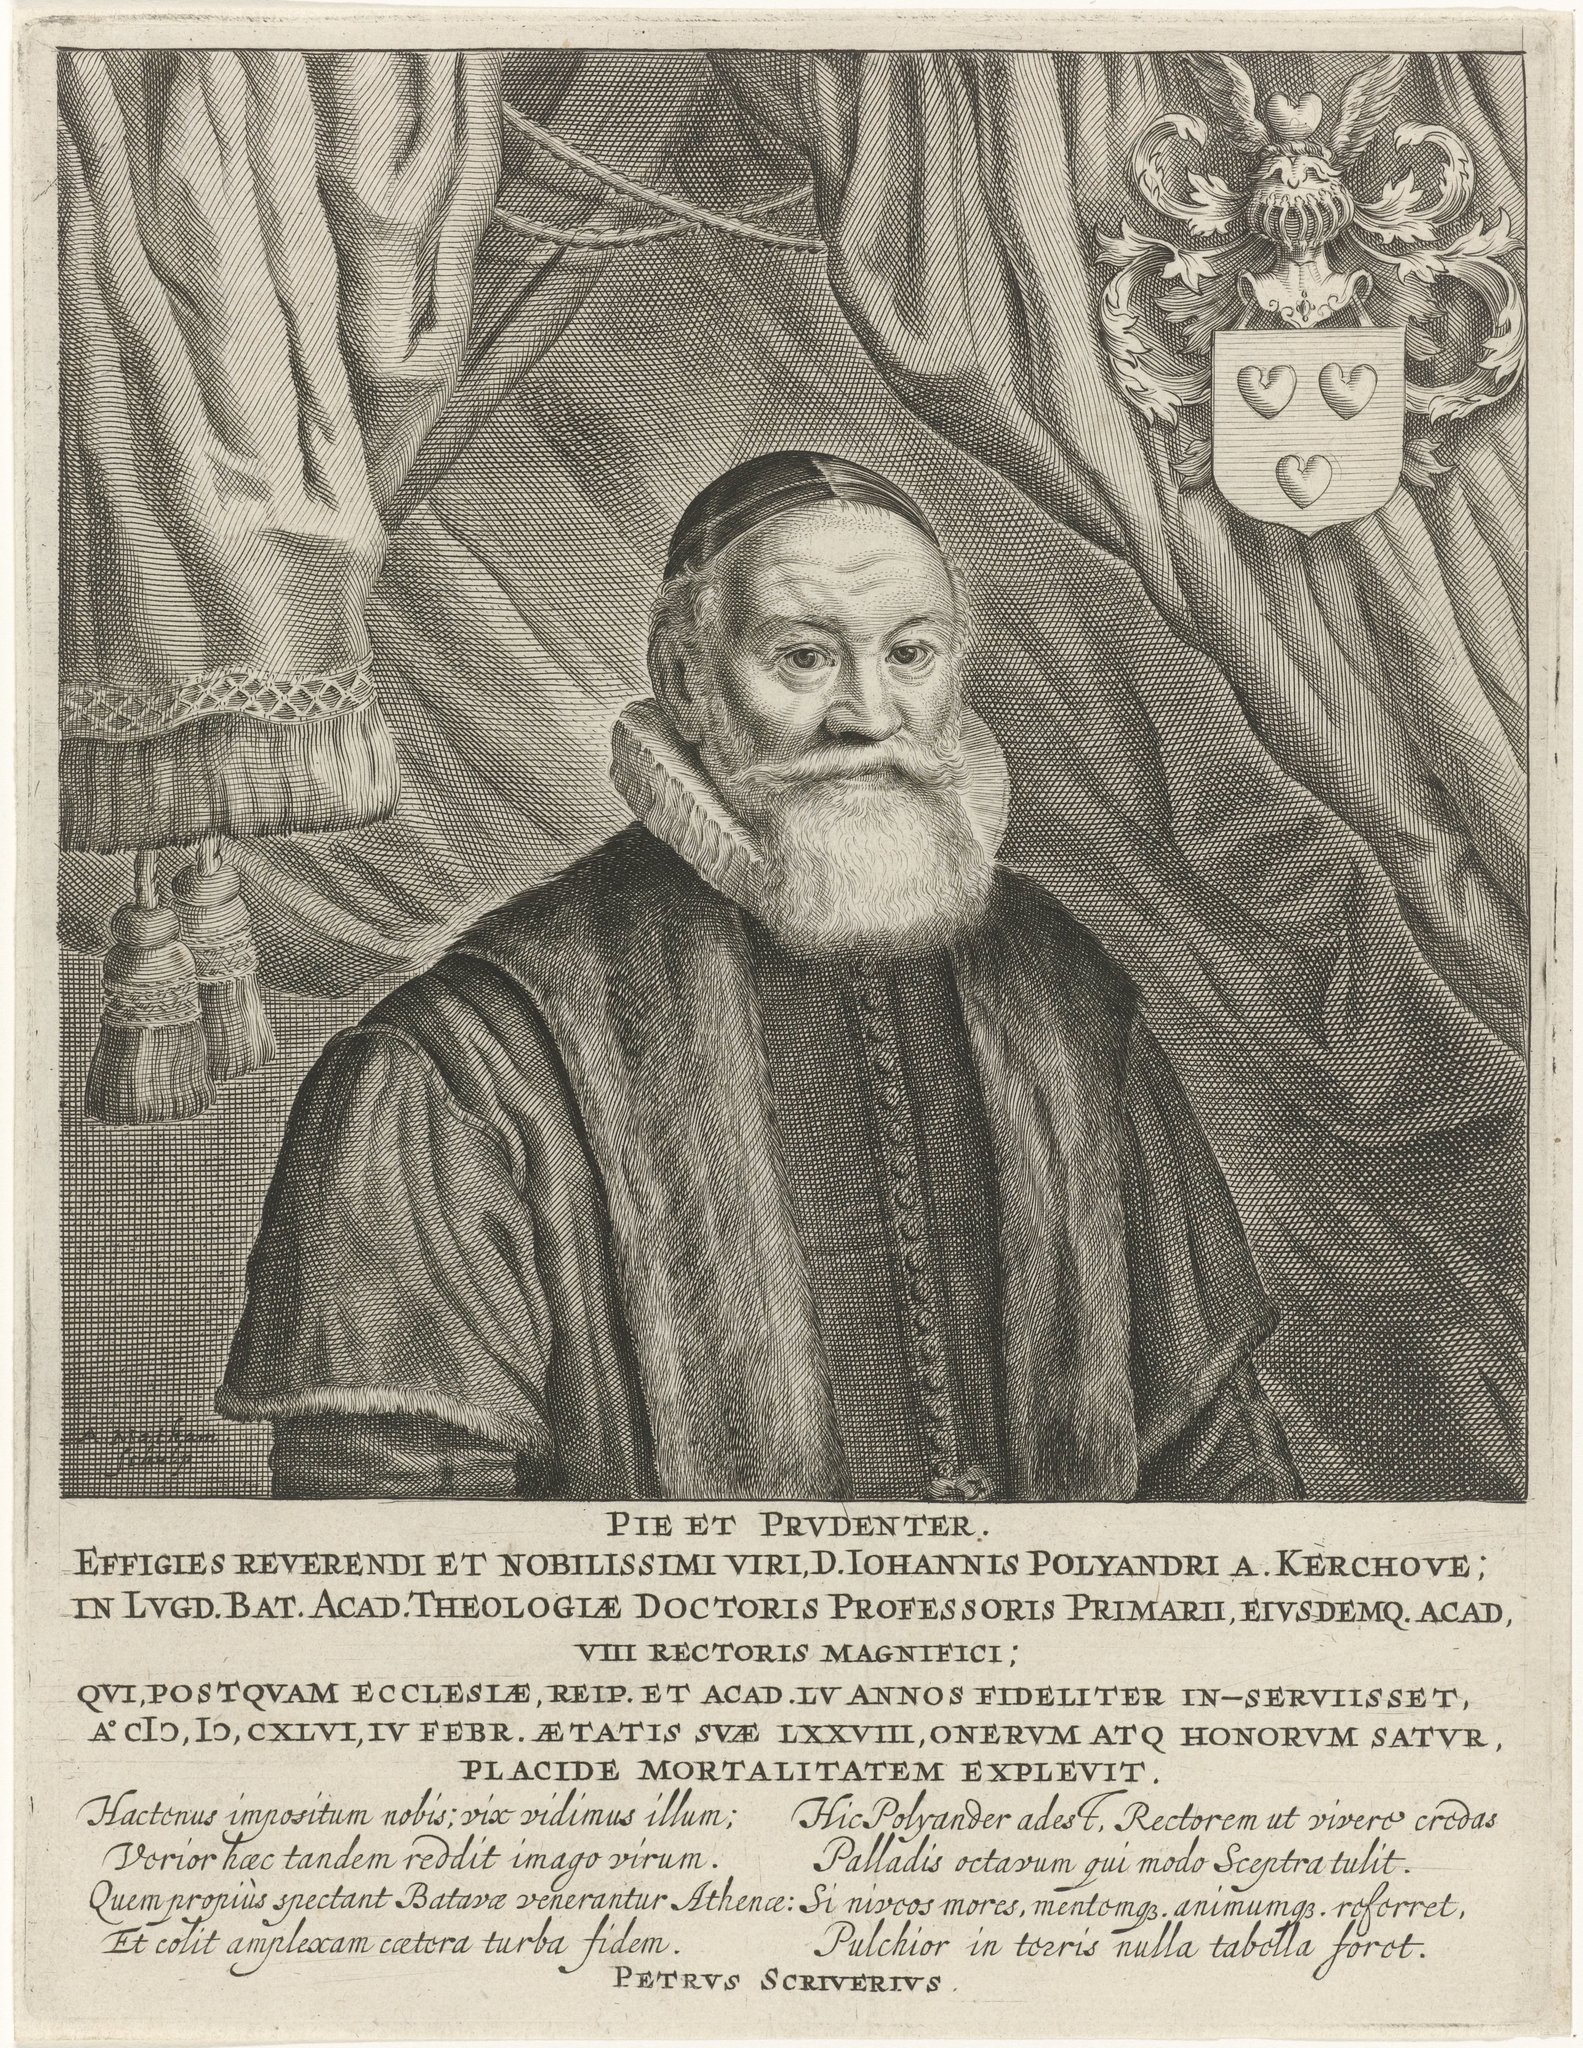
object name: print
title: Portret van Johannes Polyander van Kerkhoven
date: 1646-1660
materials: paper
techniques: engraving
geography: the hague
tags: leiden, theologian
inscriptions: collector's mark: Lugt 2228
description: Portret van Johannes Polyander van Kerkhoven, theoloog in Leiden.